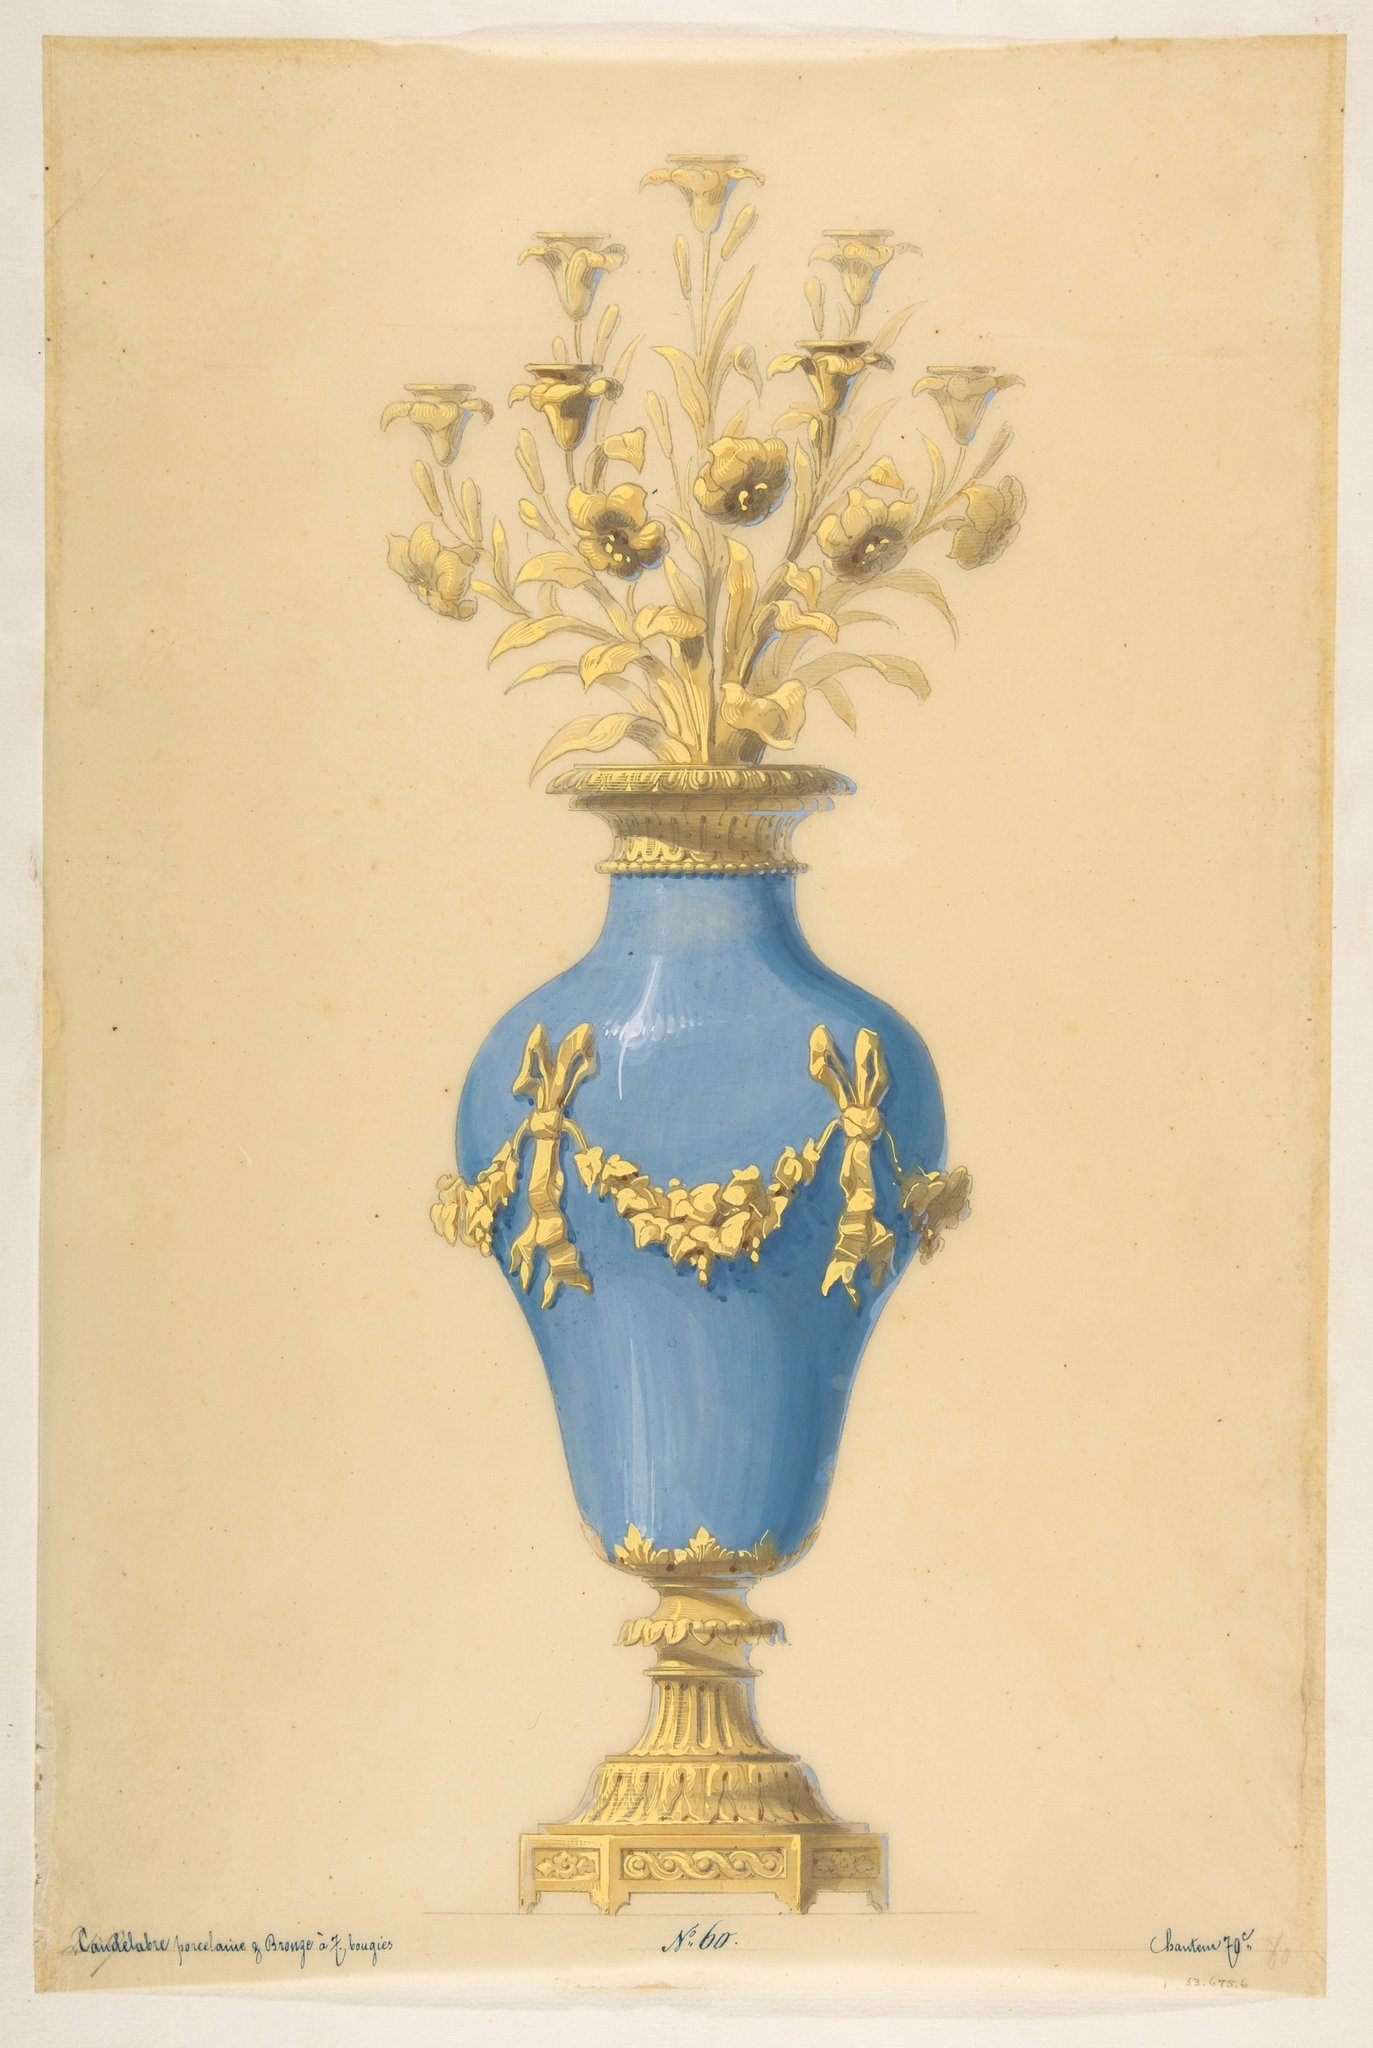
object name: drawing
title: Design for a Porcelain Candelabra with Seven Branches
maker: anonymous, french, 19th century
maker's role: artist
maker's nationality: french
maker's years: 1800-1900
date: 1801-1900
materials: gouache, graphite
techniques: brush, wash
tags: candelabra